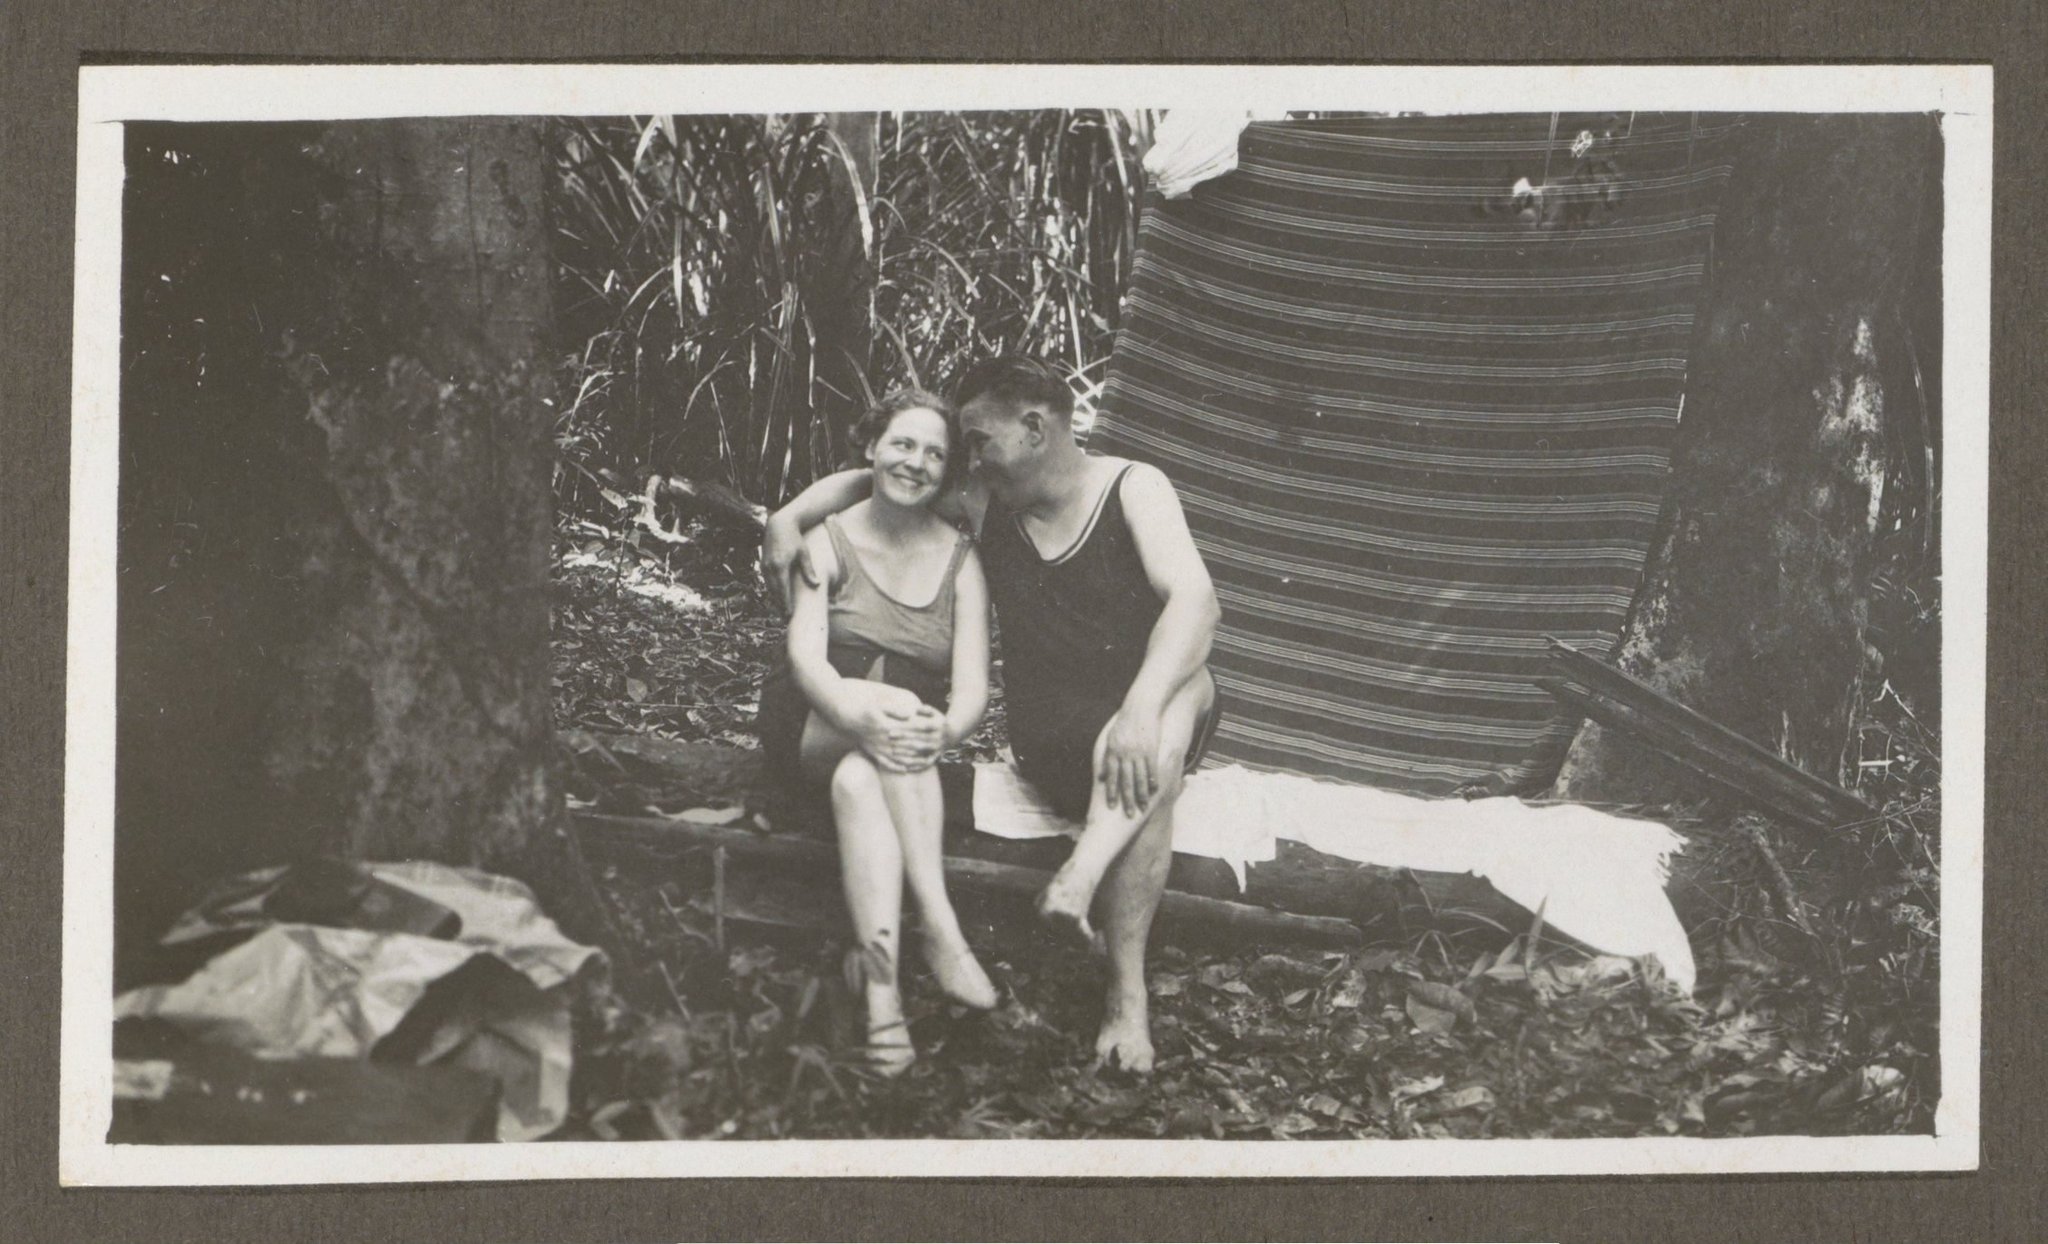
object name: photograph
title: Man en een vrouw in zwemkleding op een bank in een bos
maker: Anonymous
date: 1920-1930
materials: photographic support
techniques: gelatin silver print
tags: swimming (sport) (+ equipment, outfit (sports, games, etc.)), clothes, costume (+ women's clothes), clothes, costume (+ men's clothes), dutch east indies, the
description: Onderdeel van familiealbum Nederlands-Indië.